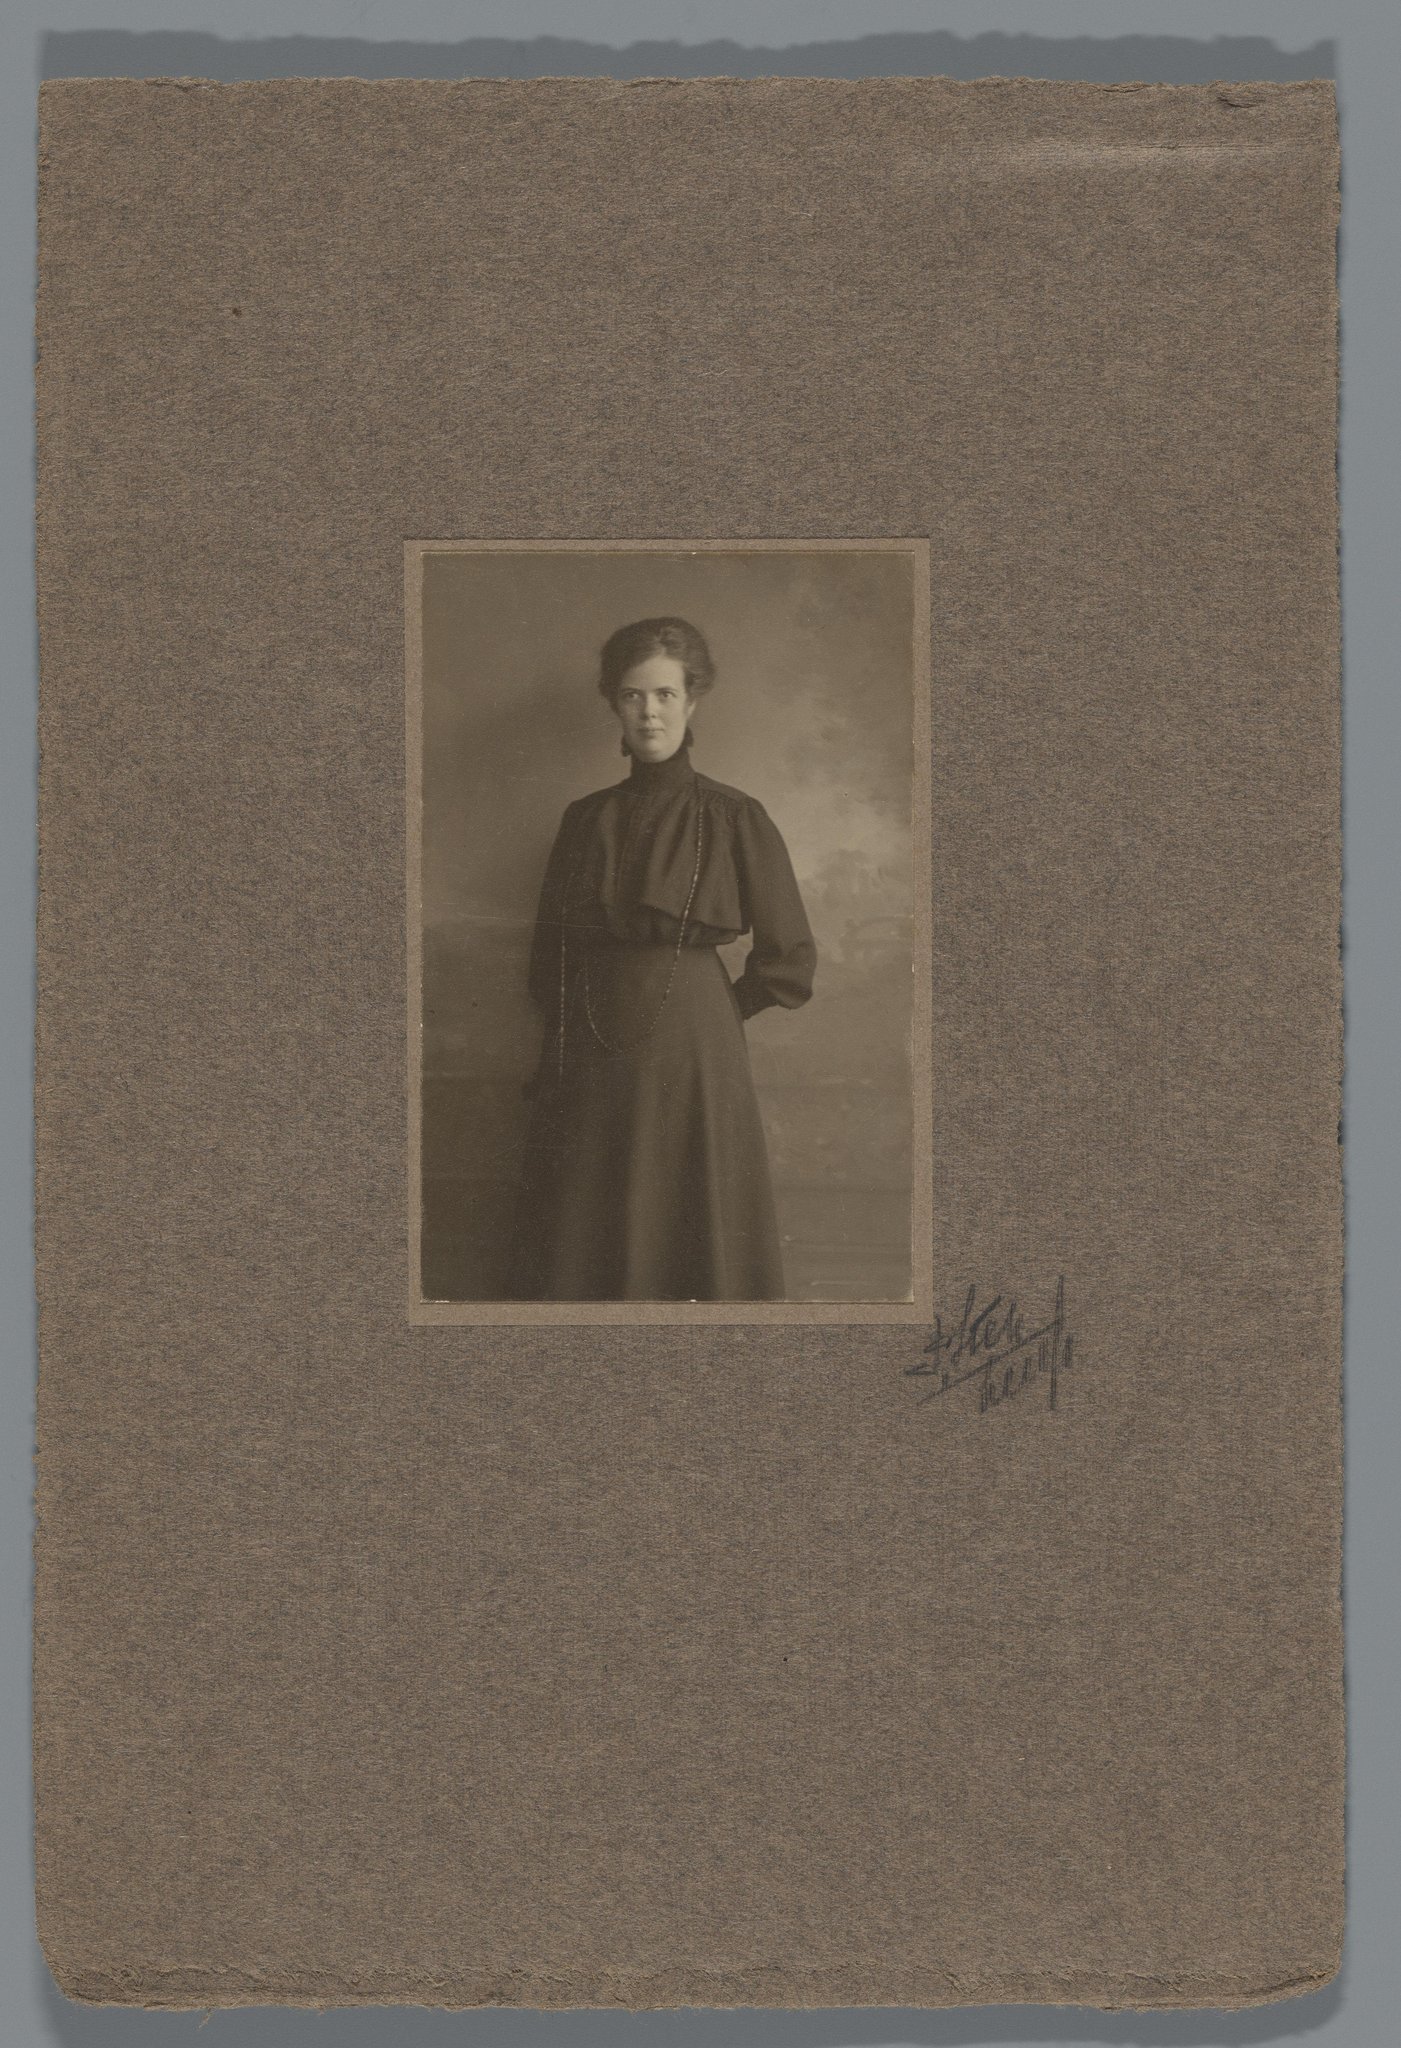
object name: photograph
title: Portret van een onbekende vrouw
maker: pieter stek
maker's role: fotograaf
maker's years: 1878-1954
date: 1912-1920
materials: paper, cardboard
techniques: gelatin silver print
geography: delft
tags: historical persons - bb - woman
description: De geportretteerde vrouw is ook afgebeeld op RP-F-F20471.